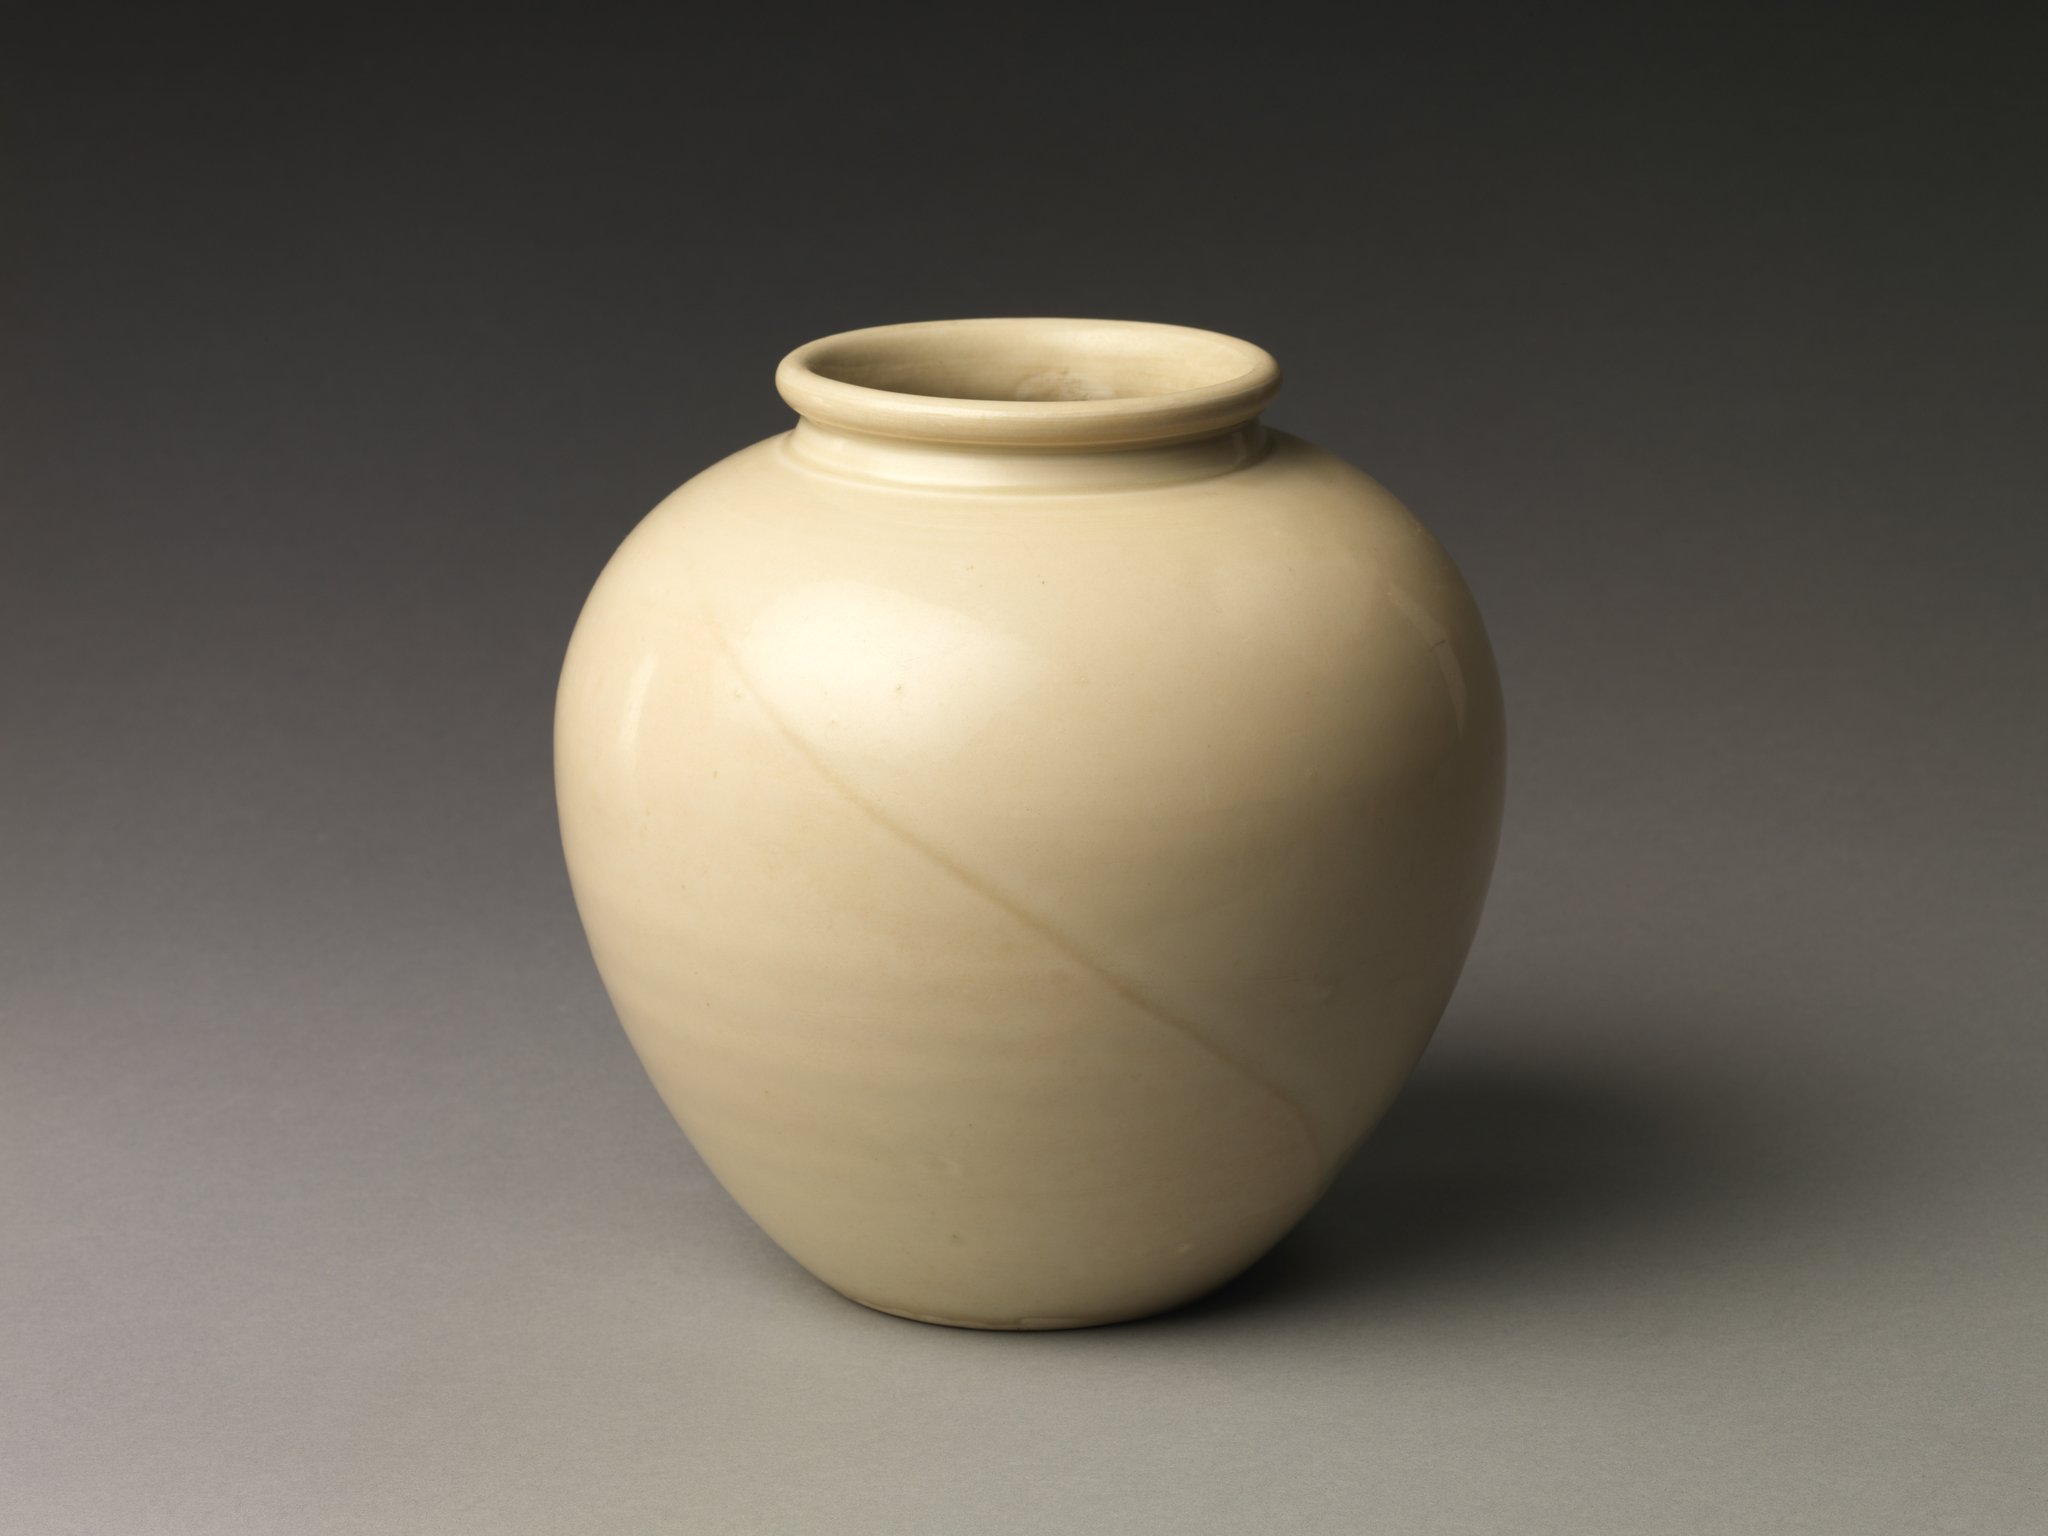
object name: jar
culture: chinese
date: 601-733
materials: glaze, porcelain